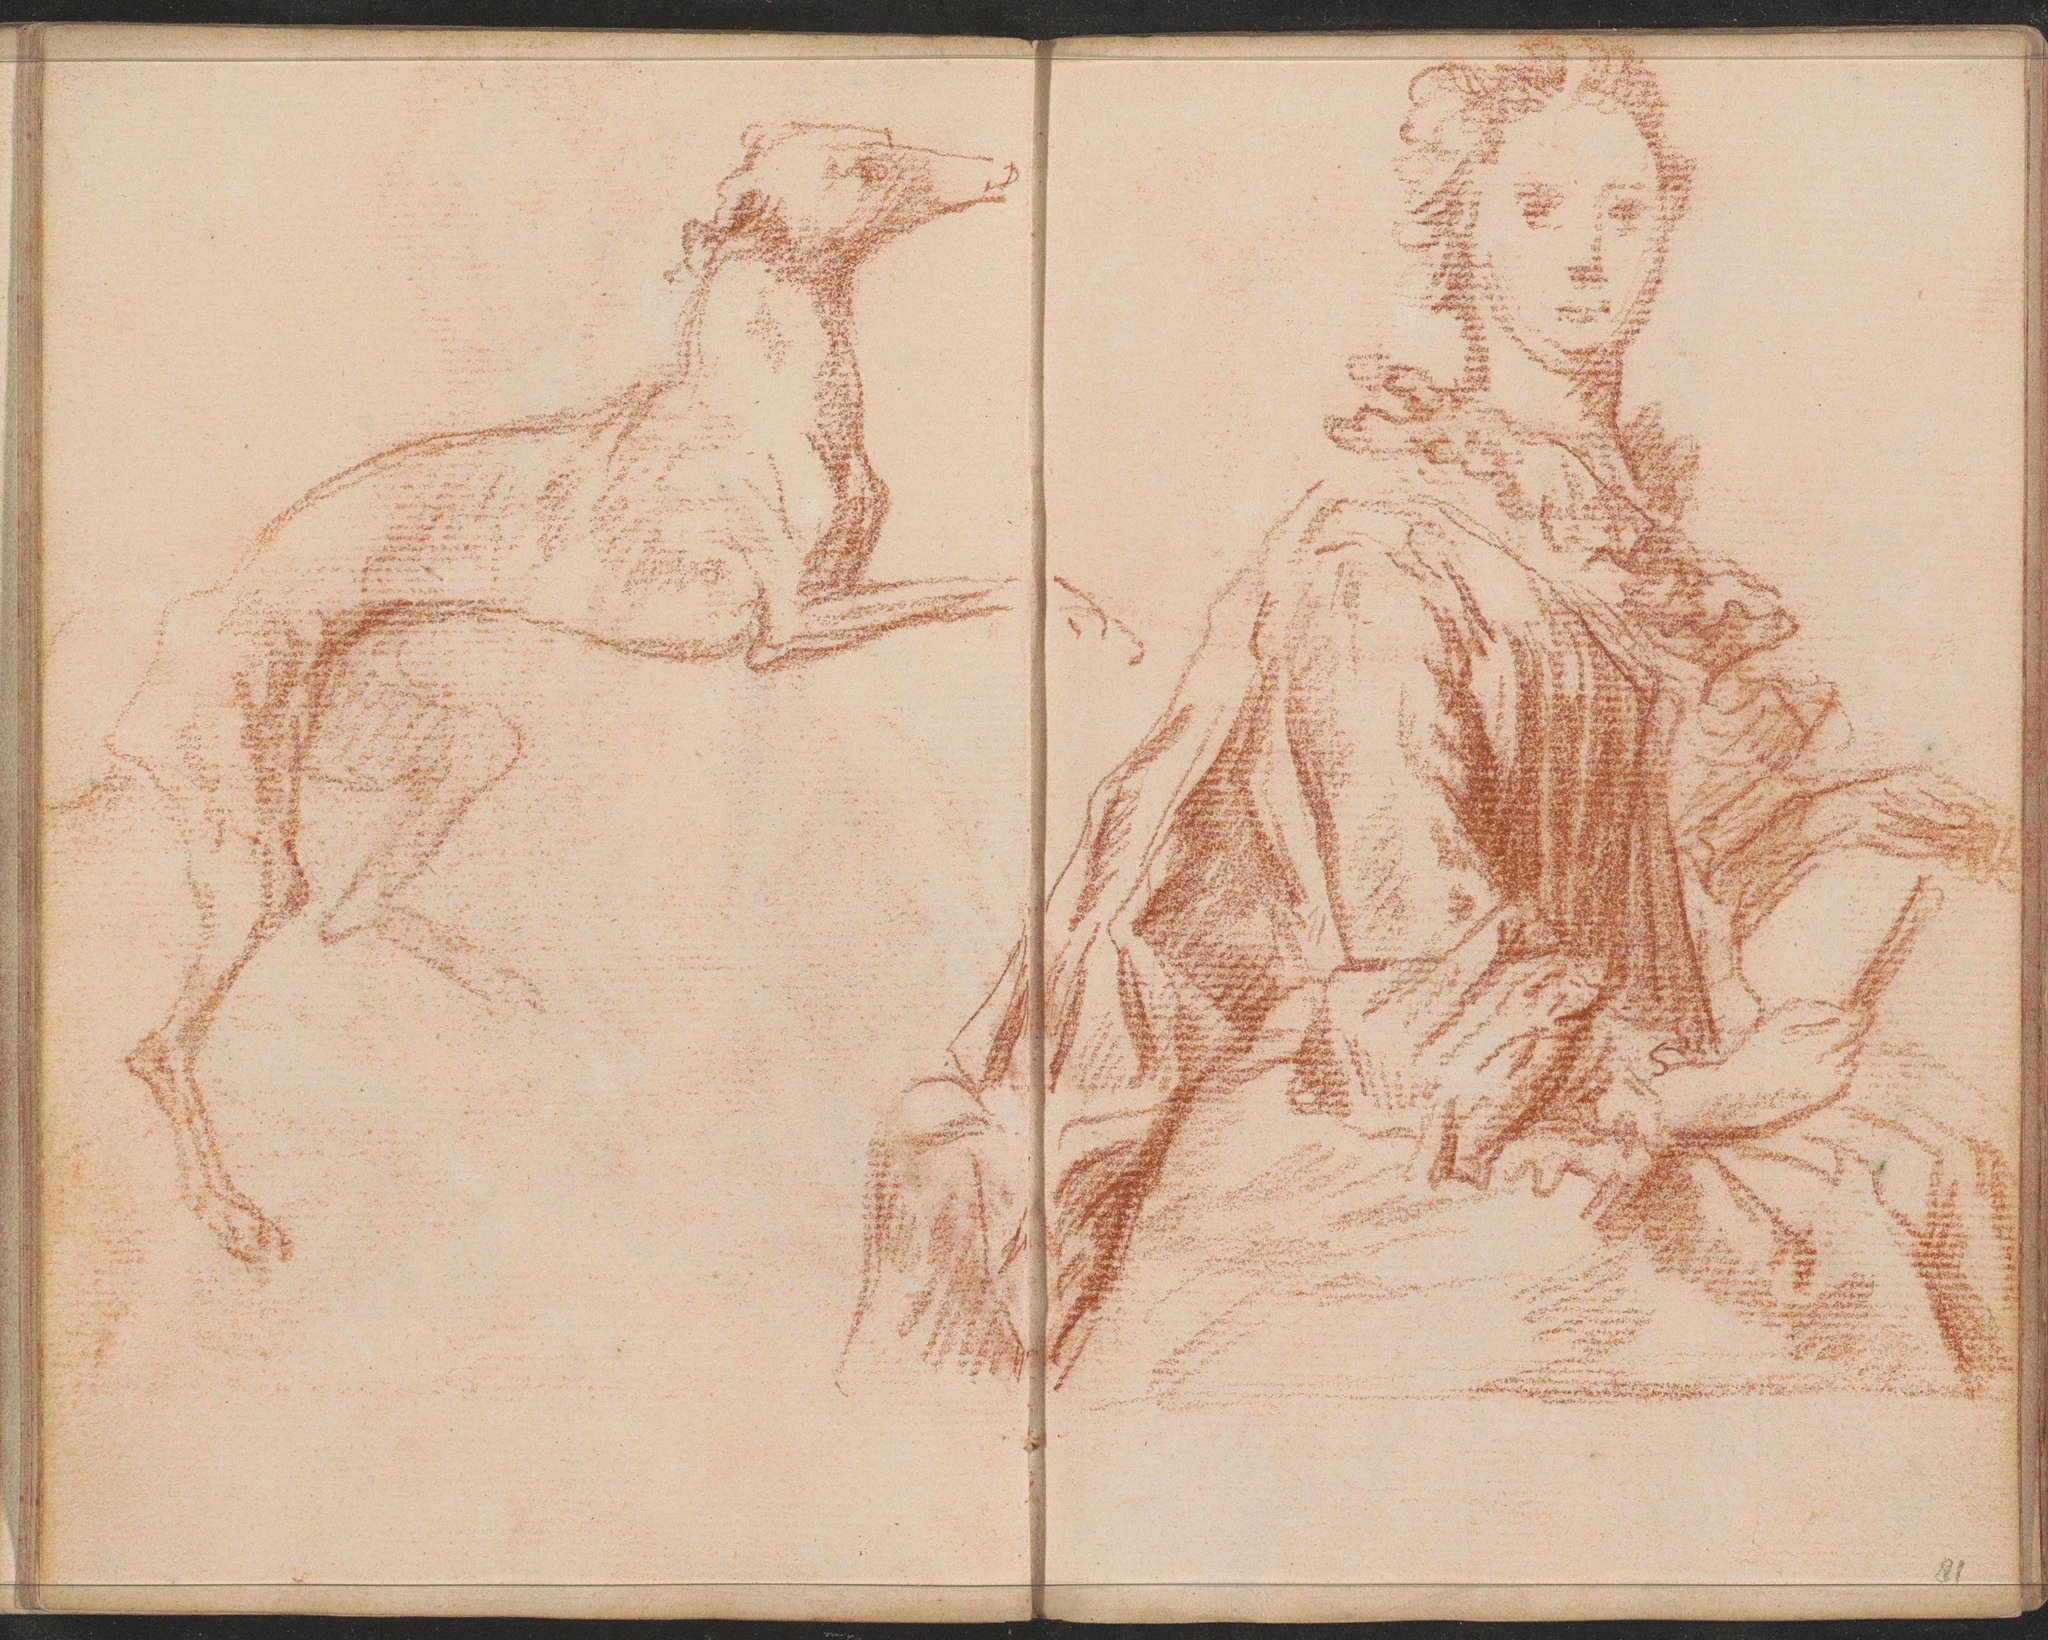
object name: sketchbook leaf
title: Hond en een zittende vrouw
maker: petrus johannes van reysschoot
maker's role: draughtsman, print maker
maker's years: 1702-1772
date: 1710-1772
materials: chalk, paper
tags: sitting figure - aa - female human figure, dog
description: De vrouw heeft een voorwerp, mogelijk een waaier, in haar rechterhand. Blad 80 verso en 81 recto uit een schetsboek met 105 bladen.